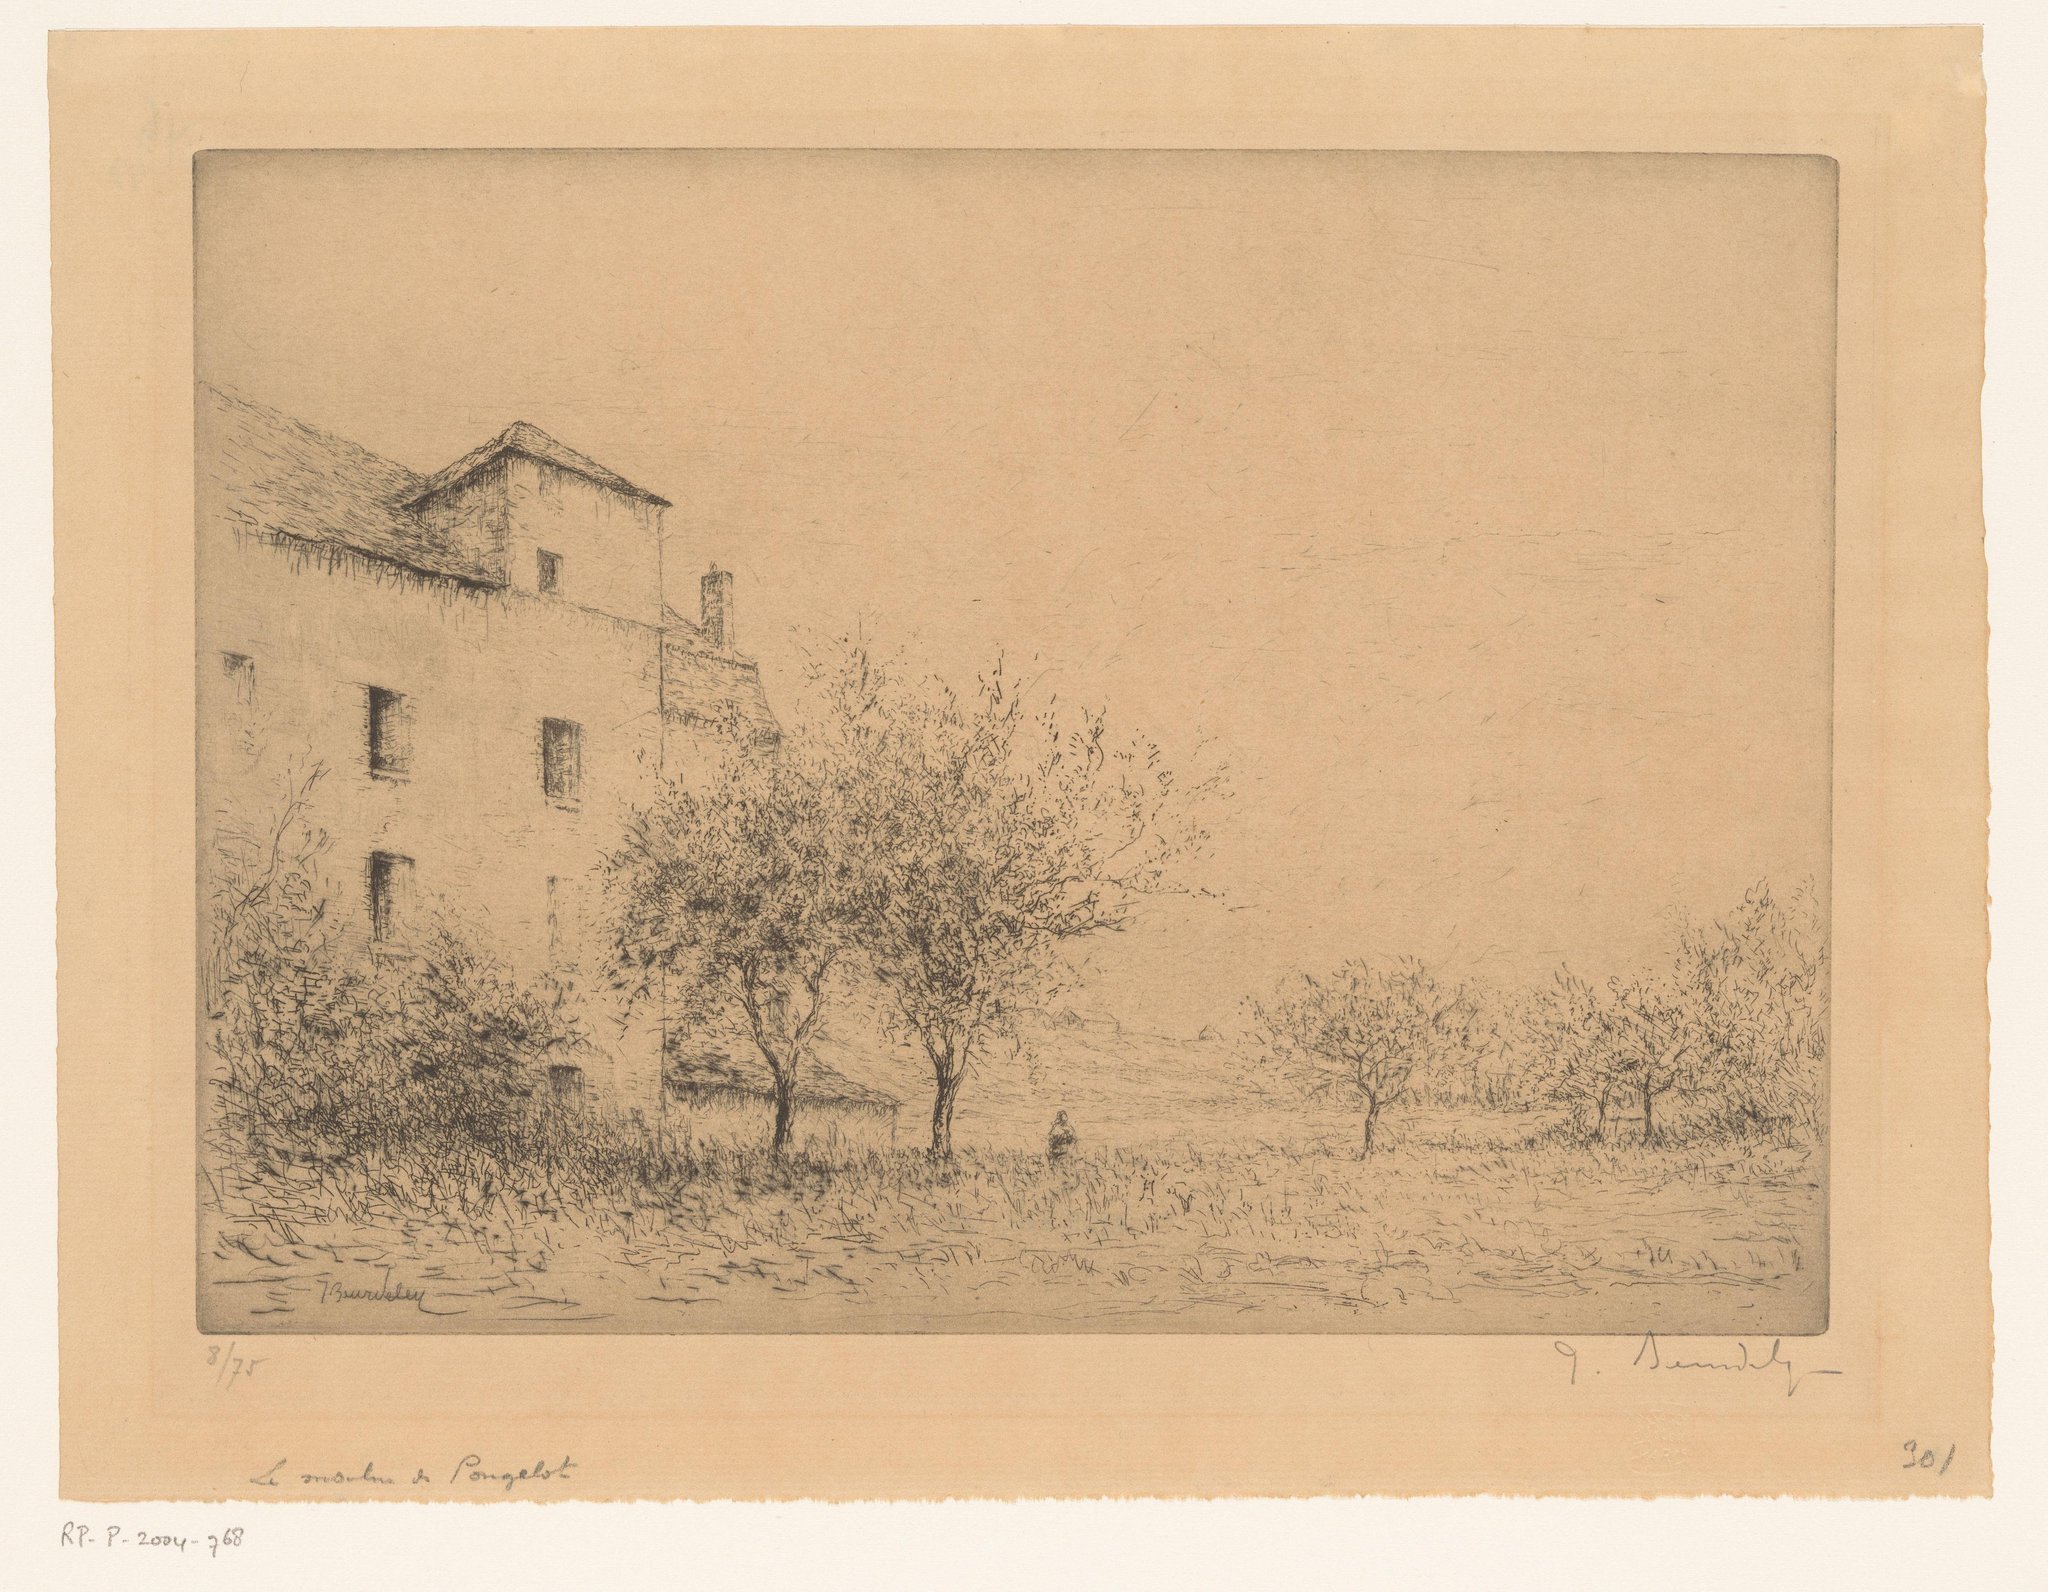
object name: print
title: Le moulin a Pougelot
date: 1929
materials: paper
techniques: drypoint, etching, intaglio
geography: paris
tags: trees, rural housing, e.g. country-house, villa, cottage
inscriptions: check stamp: Lugt 2254, collector's mark: Lugt 2228